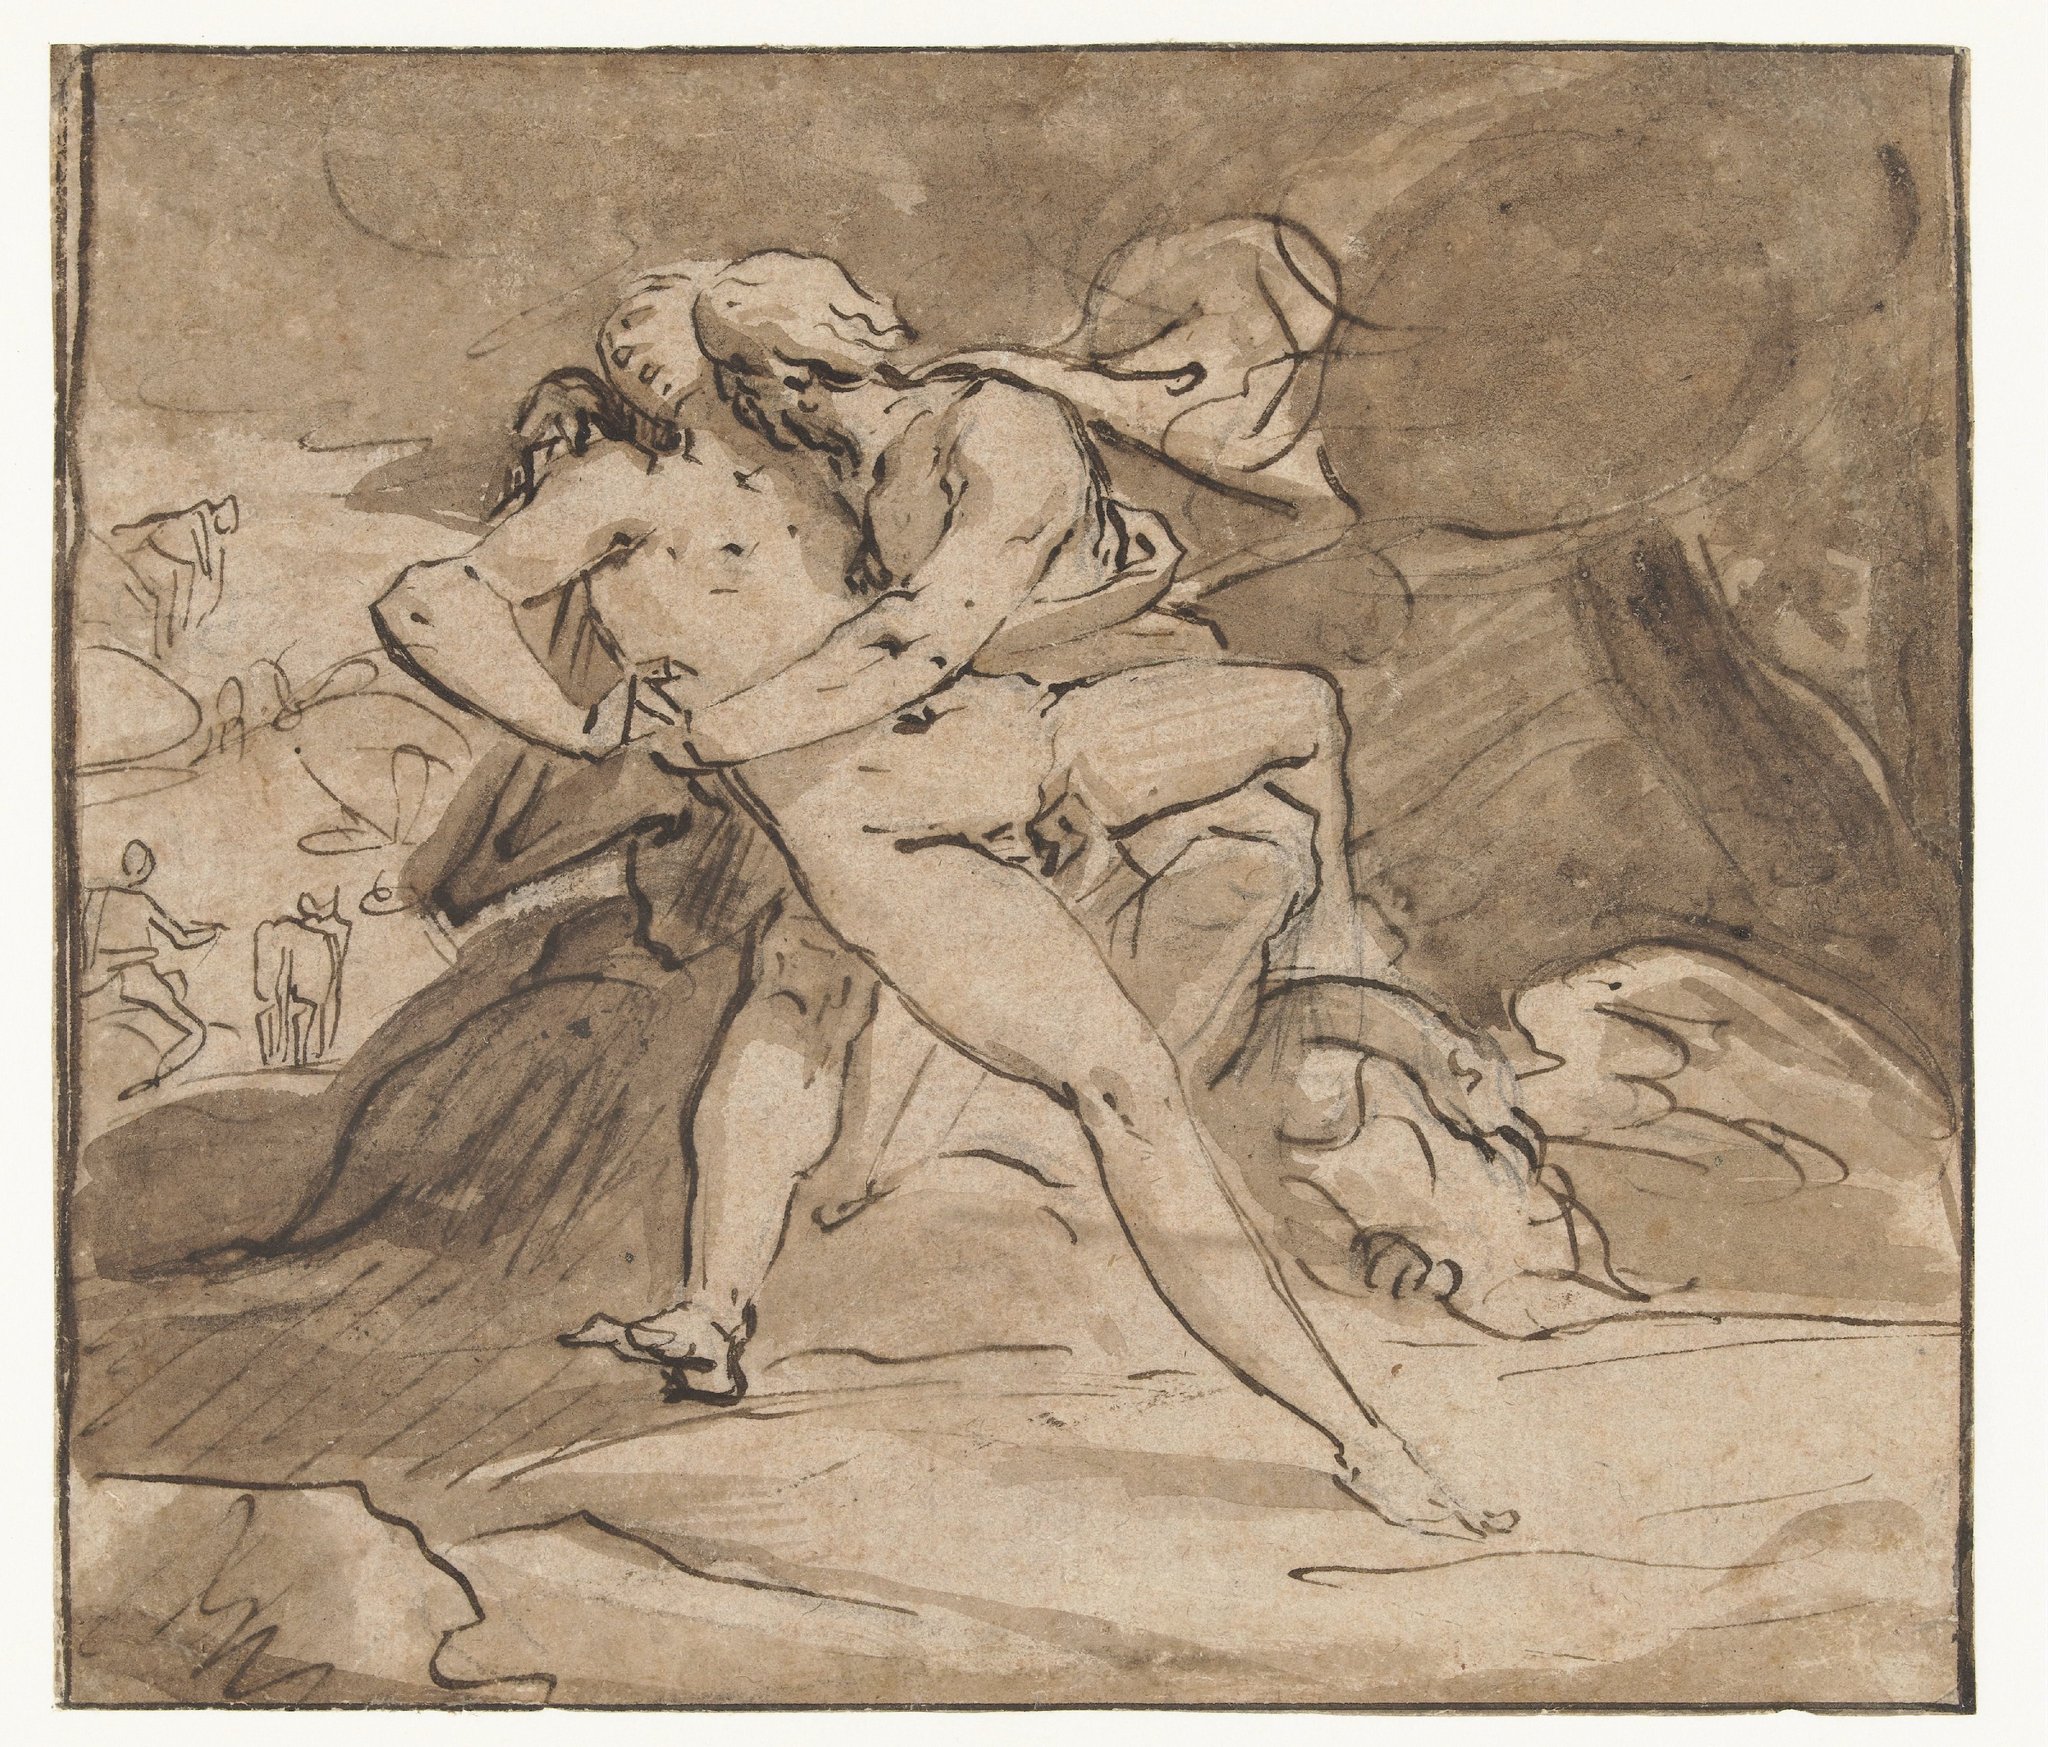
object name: drawing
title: Jupiter omhelst Io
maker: jan harmensz. muller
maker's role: draughtsman, print maker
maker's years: 1571-1628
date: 1590-1595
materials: chalk, ink, paper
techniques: brush, pen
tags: jupiter, shrouded in a cloud, woos io, daughter of inachus; juno may be watching the lovers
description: De voorstellingen van de Metamorfosen van Ovid behandelde Goltzius in zijn gravures. Toen de tekening werd aangekocht, was deze toegeschreven aan Spranger, wiens hand in deze niet onderscheiden kan worden. Reznicek, die het onderwerp interpreteerd als Jupiter en Europa, twijfelt tussen Jan Muller en Spranger. Waarschijnlijk omdat er geen gelijkenis is met bovengenoemde prent. Hij besliste in het voordeel van Spranger, hoewel hij waarnam dat Goltzius' tekenstijl de stijl van Spranger tussen 1580 en 1590 benaderde. De uitgesproken hoekige compositie is past helemaal niet bij Spranger, wat duidelijk wordt als men deze tekening vergelijkt met die in Leiden, Cupid en Psyche. Todat de gravure waar deze tekening is voor gebruikt wordt gevonden, blijft de toewijzing arbitrair.